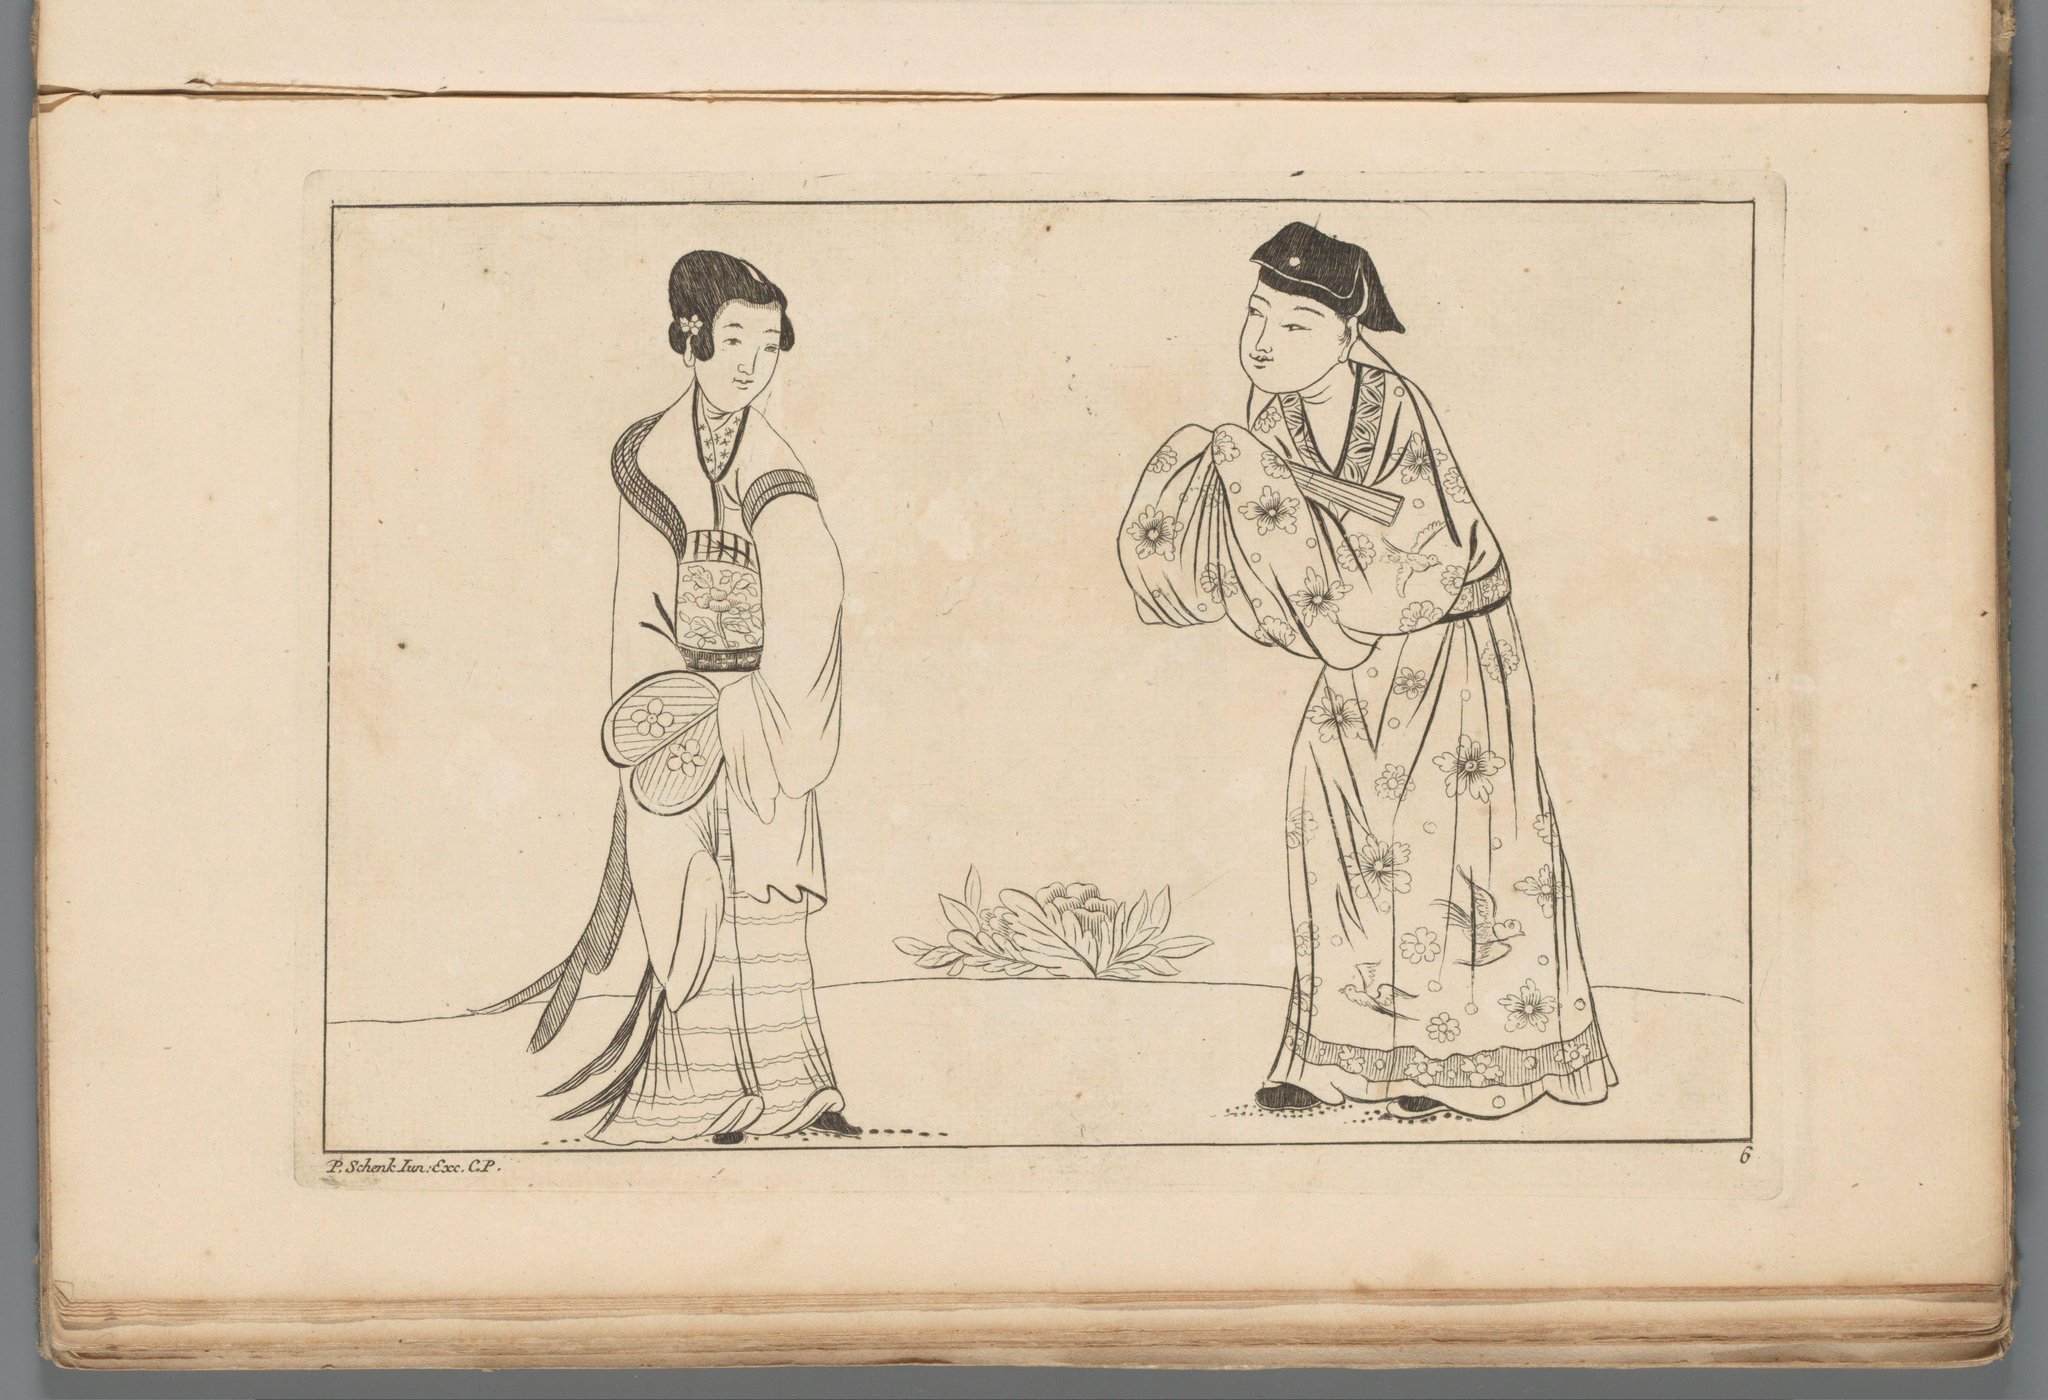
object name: album leaf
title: Chinese vrouwen, bloemen en vogels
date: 1727-1775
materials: paper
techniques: etching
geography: amsterdam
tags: chinese (+ costume), chinese, fan